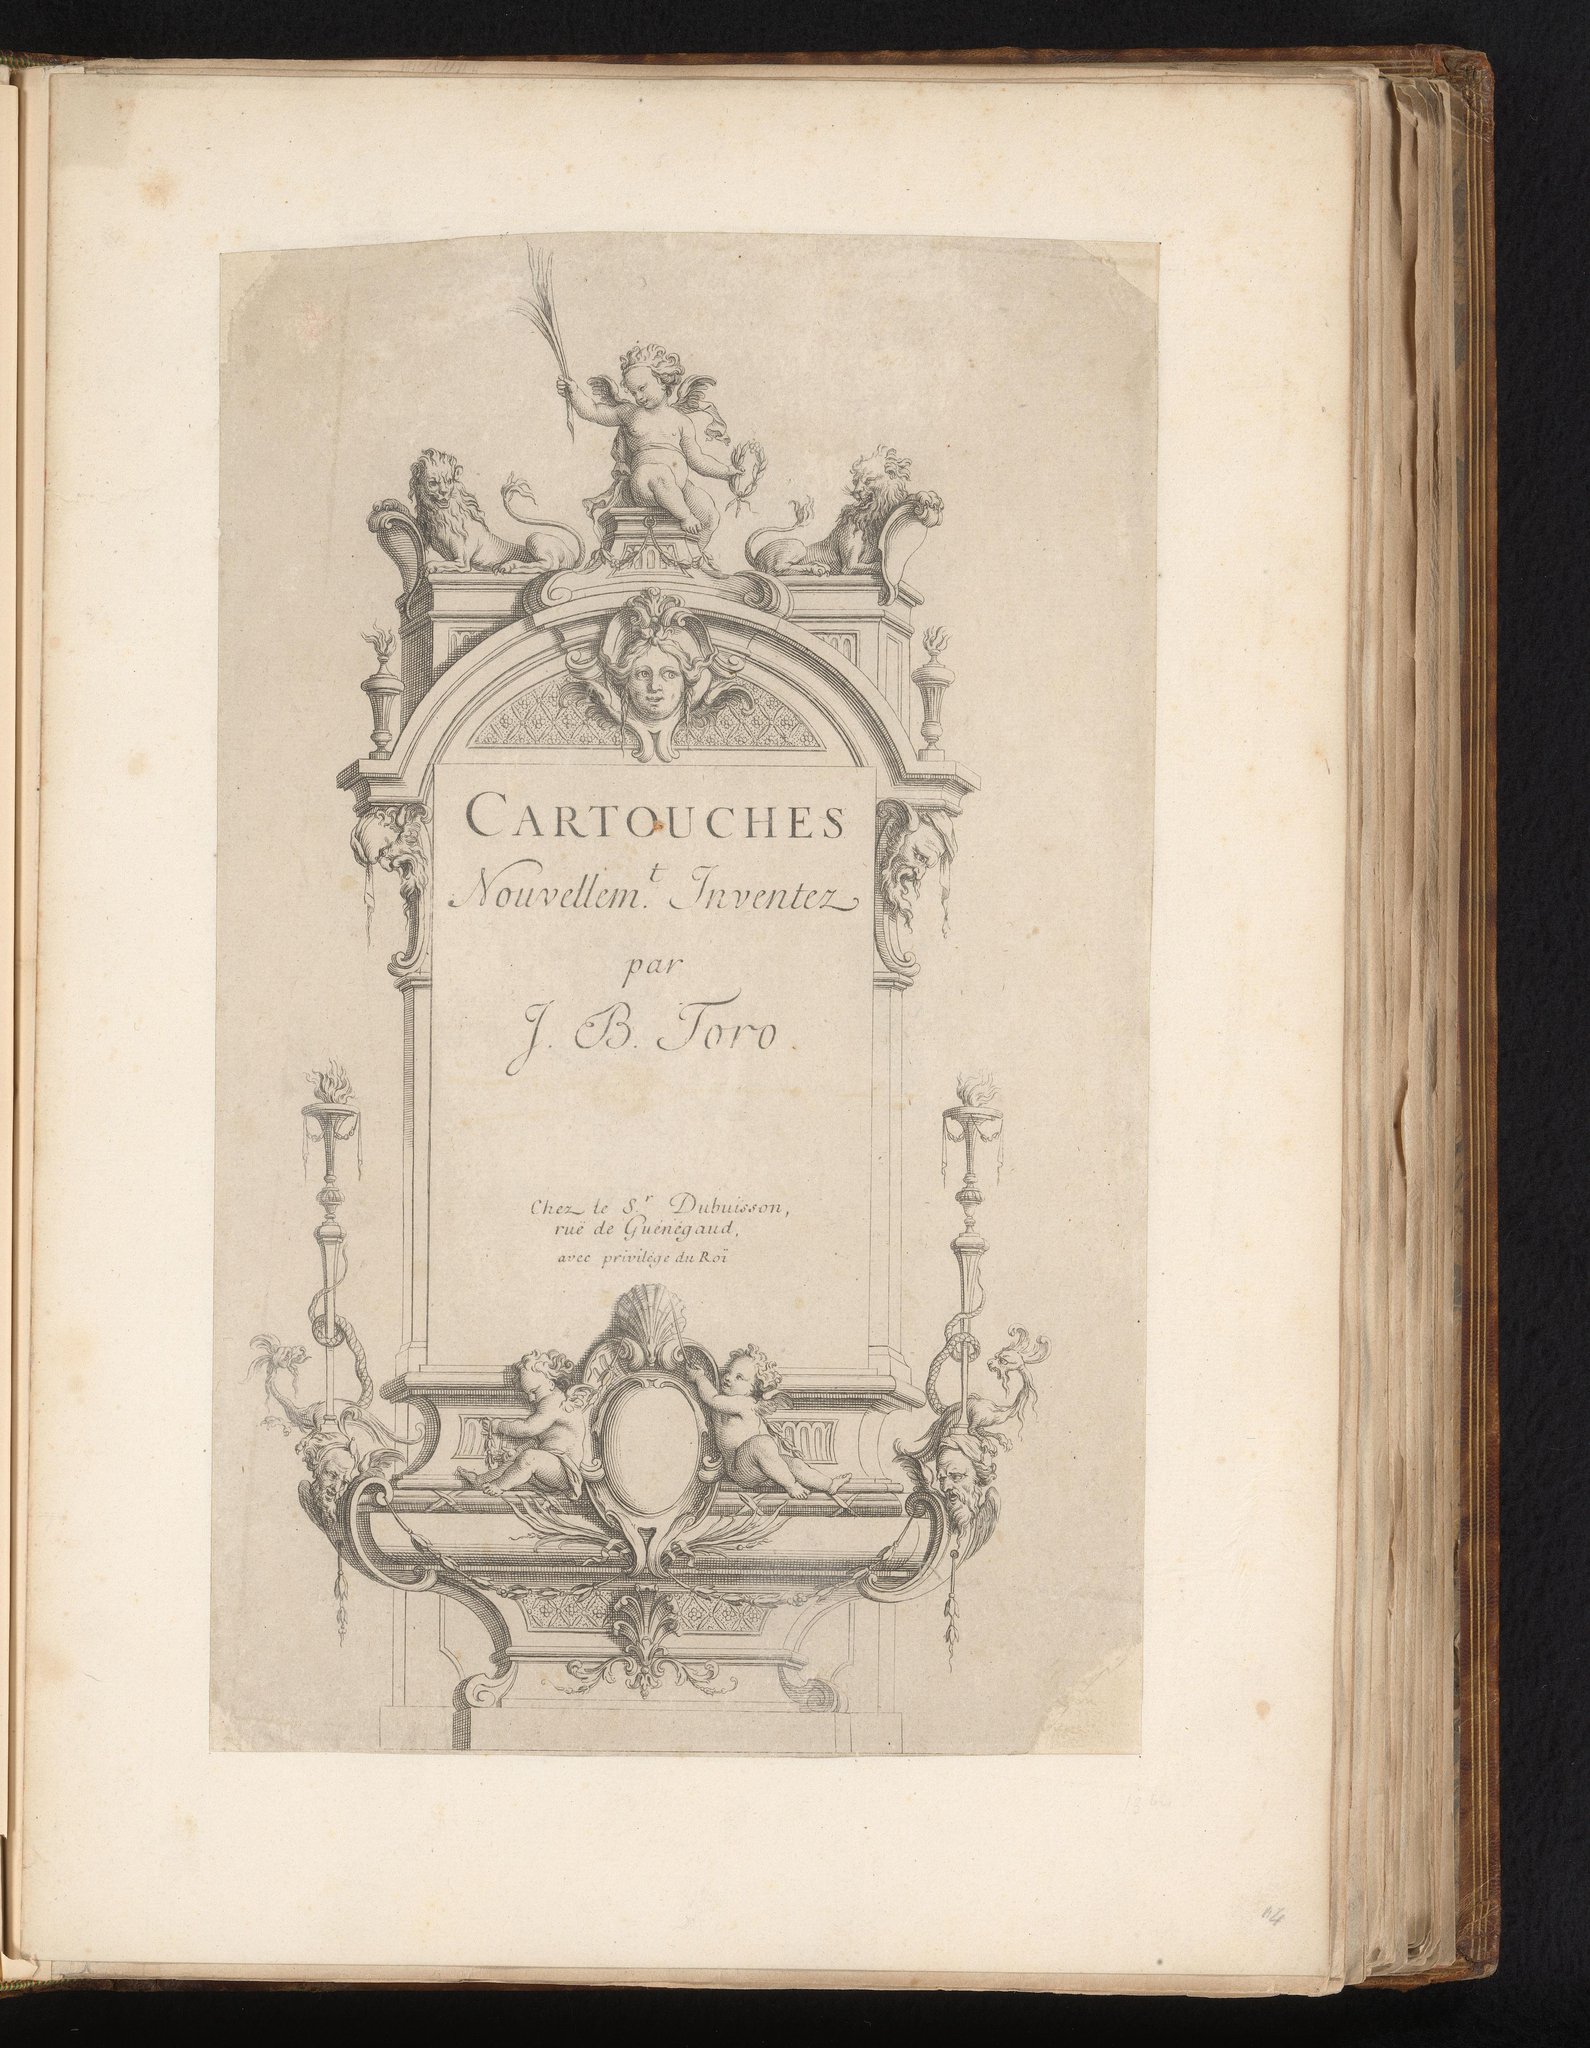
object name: ornament print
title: Ontwerpen voor cartouches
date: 1698-1731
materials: paper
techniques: engraving, etching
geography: france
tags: ornament ~ cartouche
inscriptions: collector's mark: Lugt 2760, collector's mark: Lugt 2228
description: Prent maakt deel uit van een serie van zes prenten.